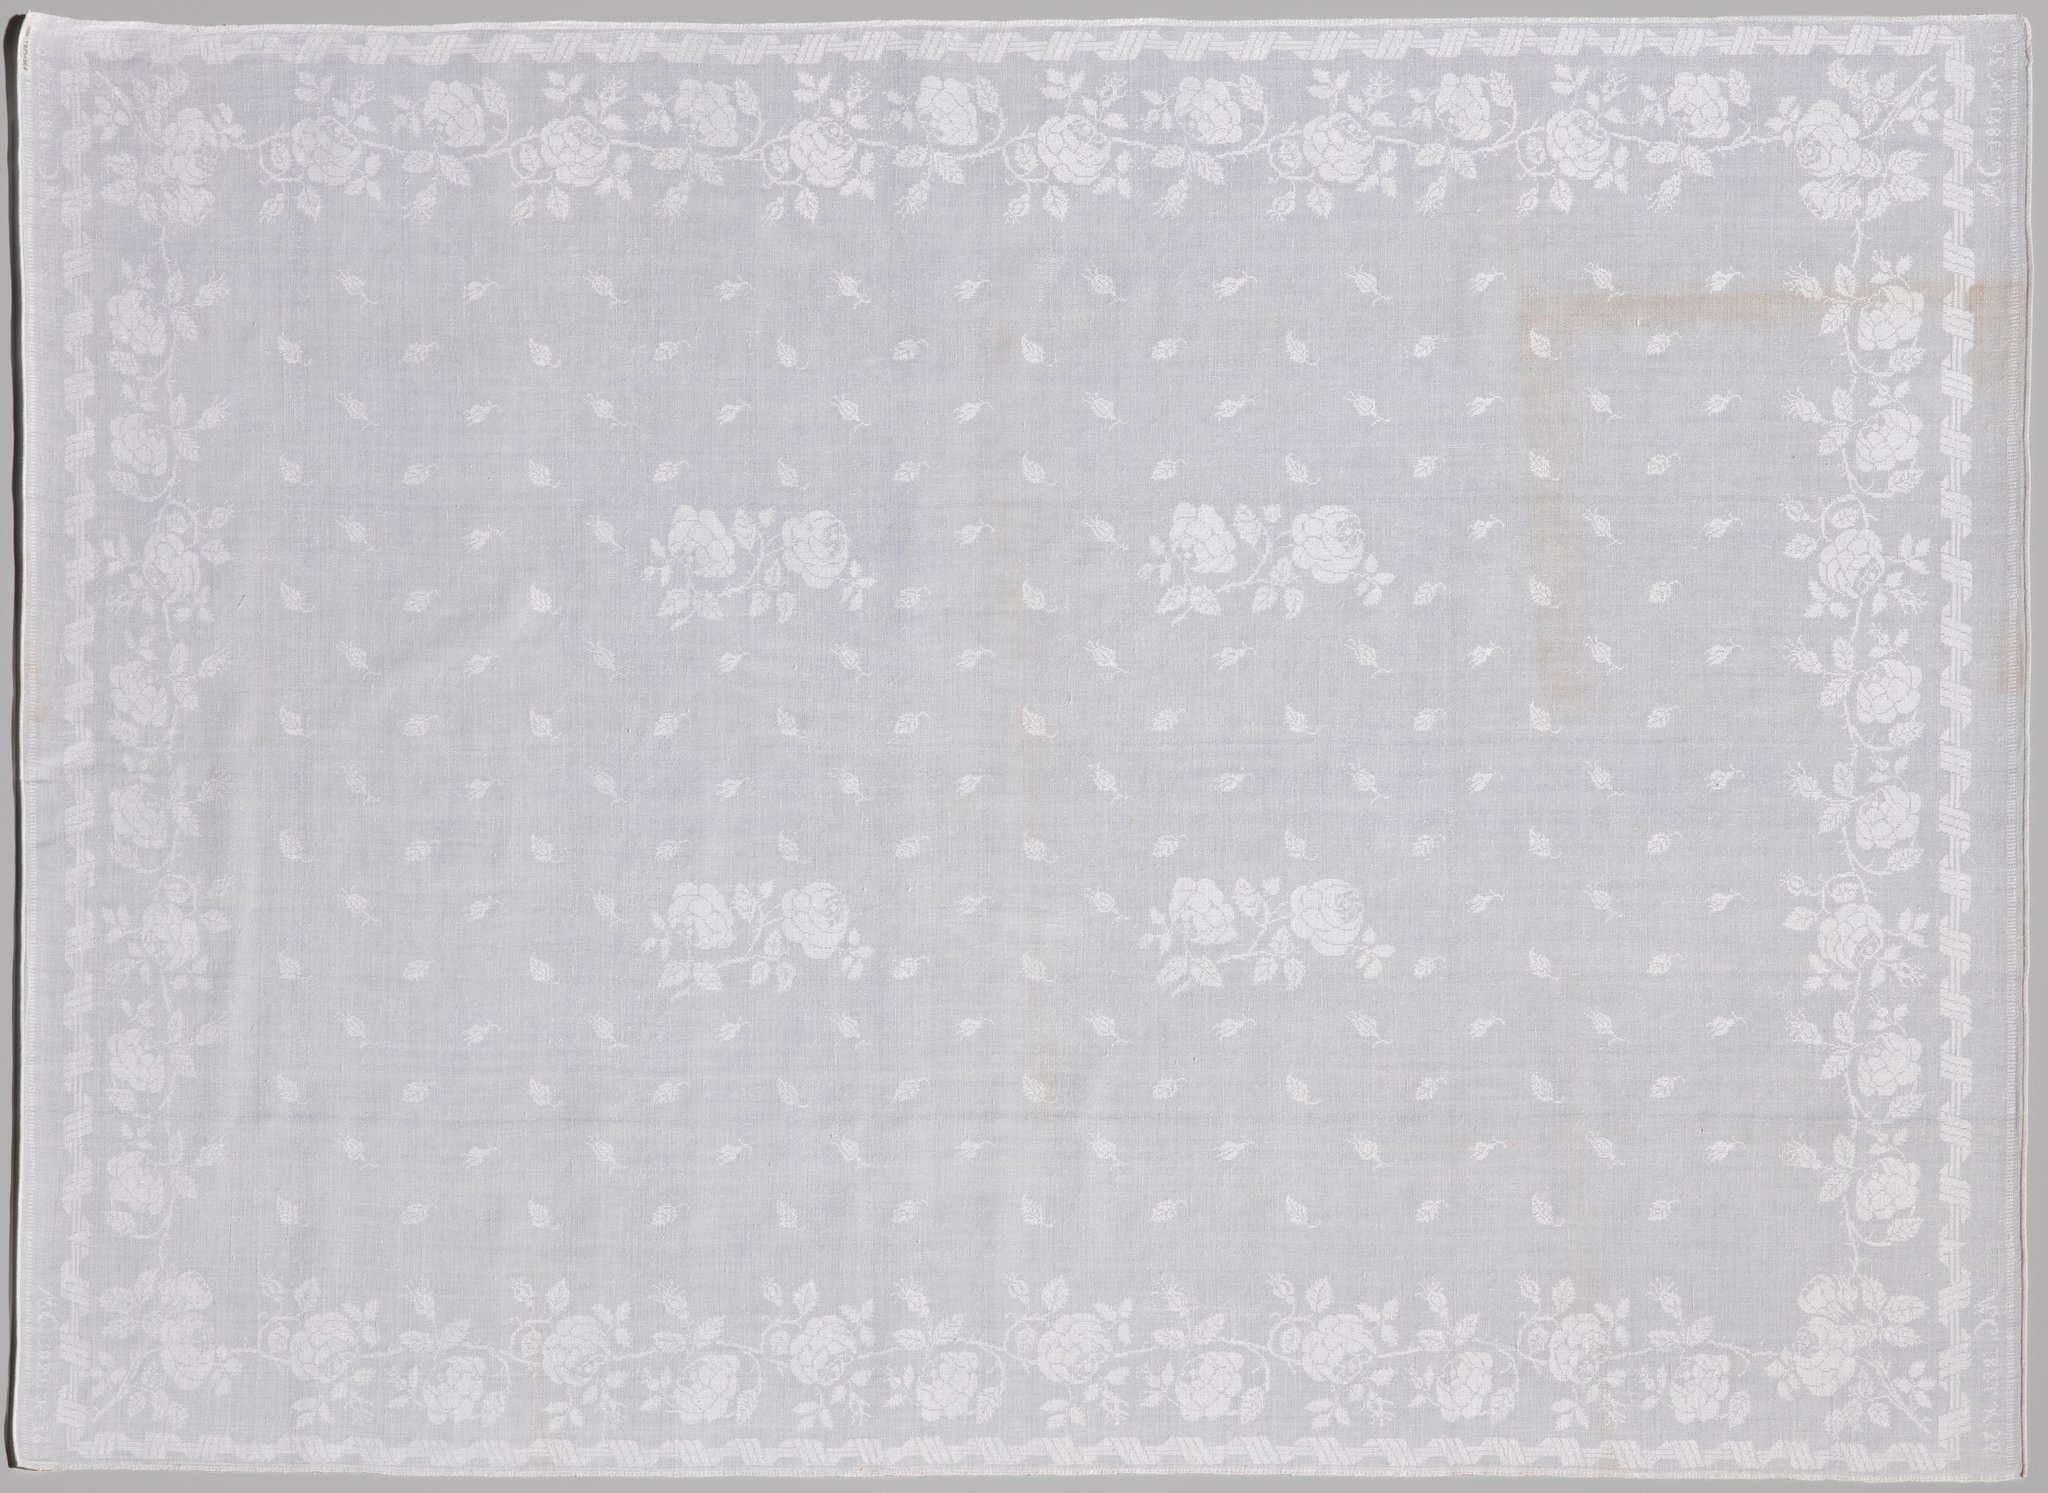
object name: napkin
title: Servet van wit linnendamast met rozenpatroon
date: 1821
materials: linen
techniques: damask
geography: netherlands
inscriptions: date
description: Witlinnen damasten servet met een rozenpatroon en de inweving MC en 1821 N 36. Met losse fragmenten, waslabel: 655.